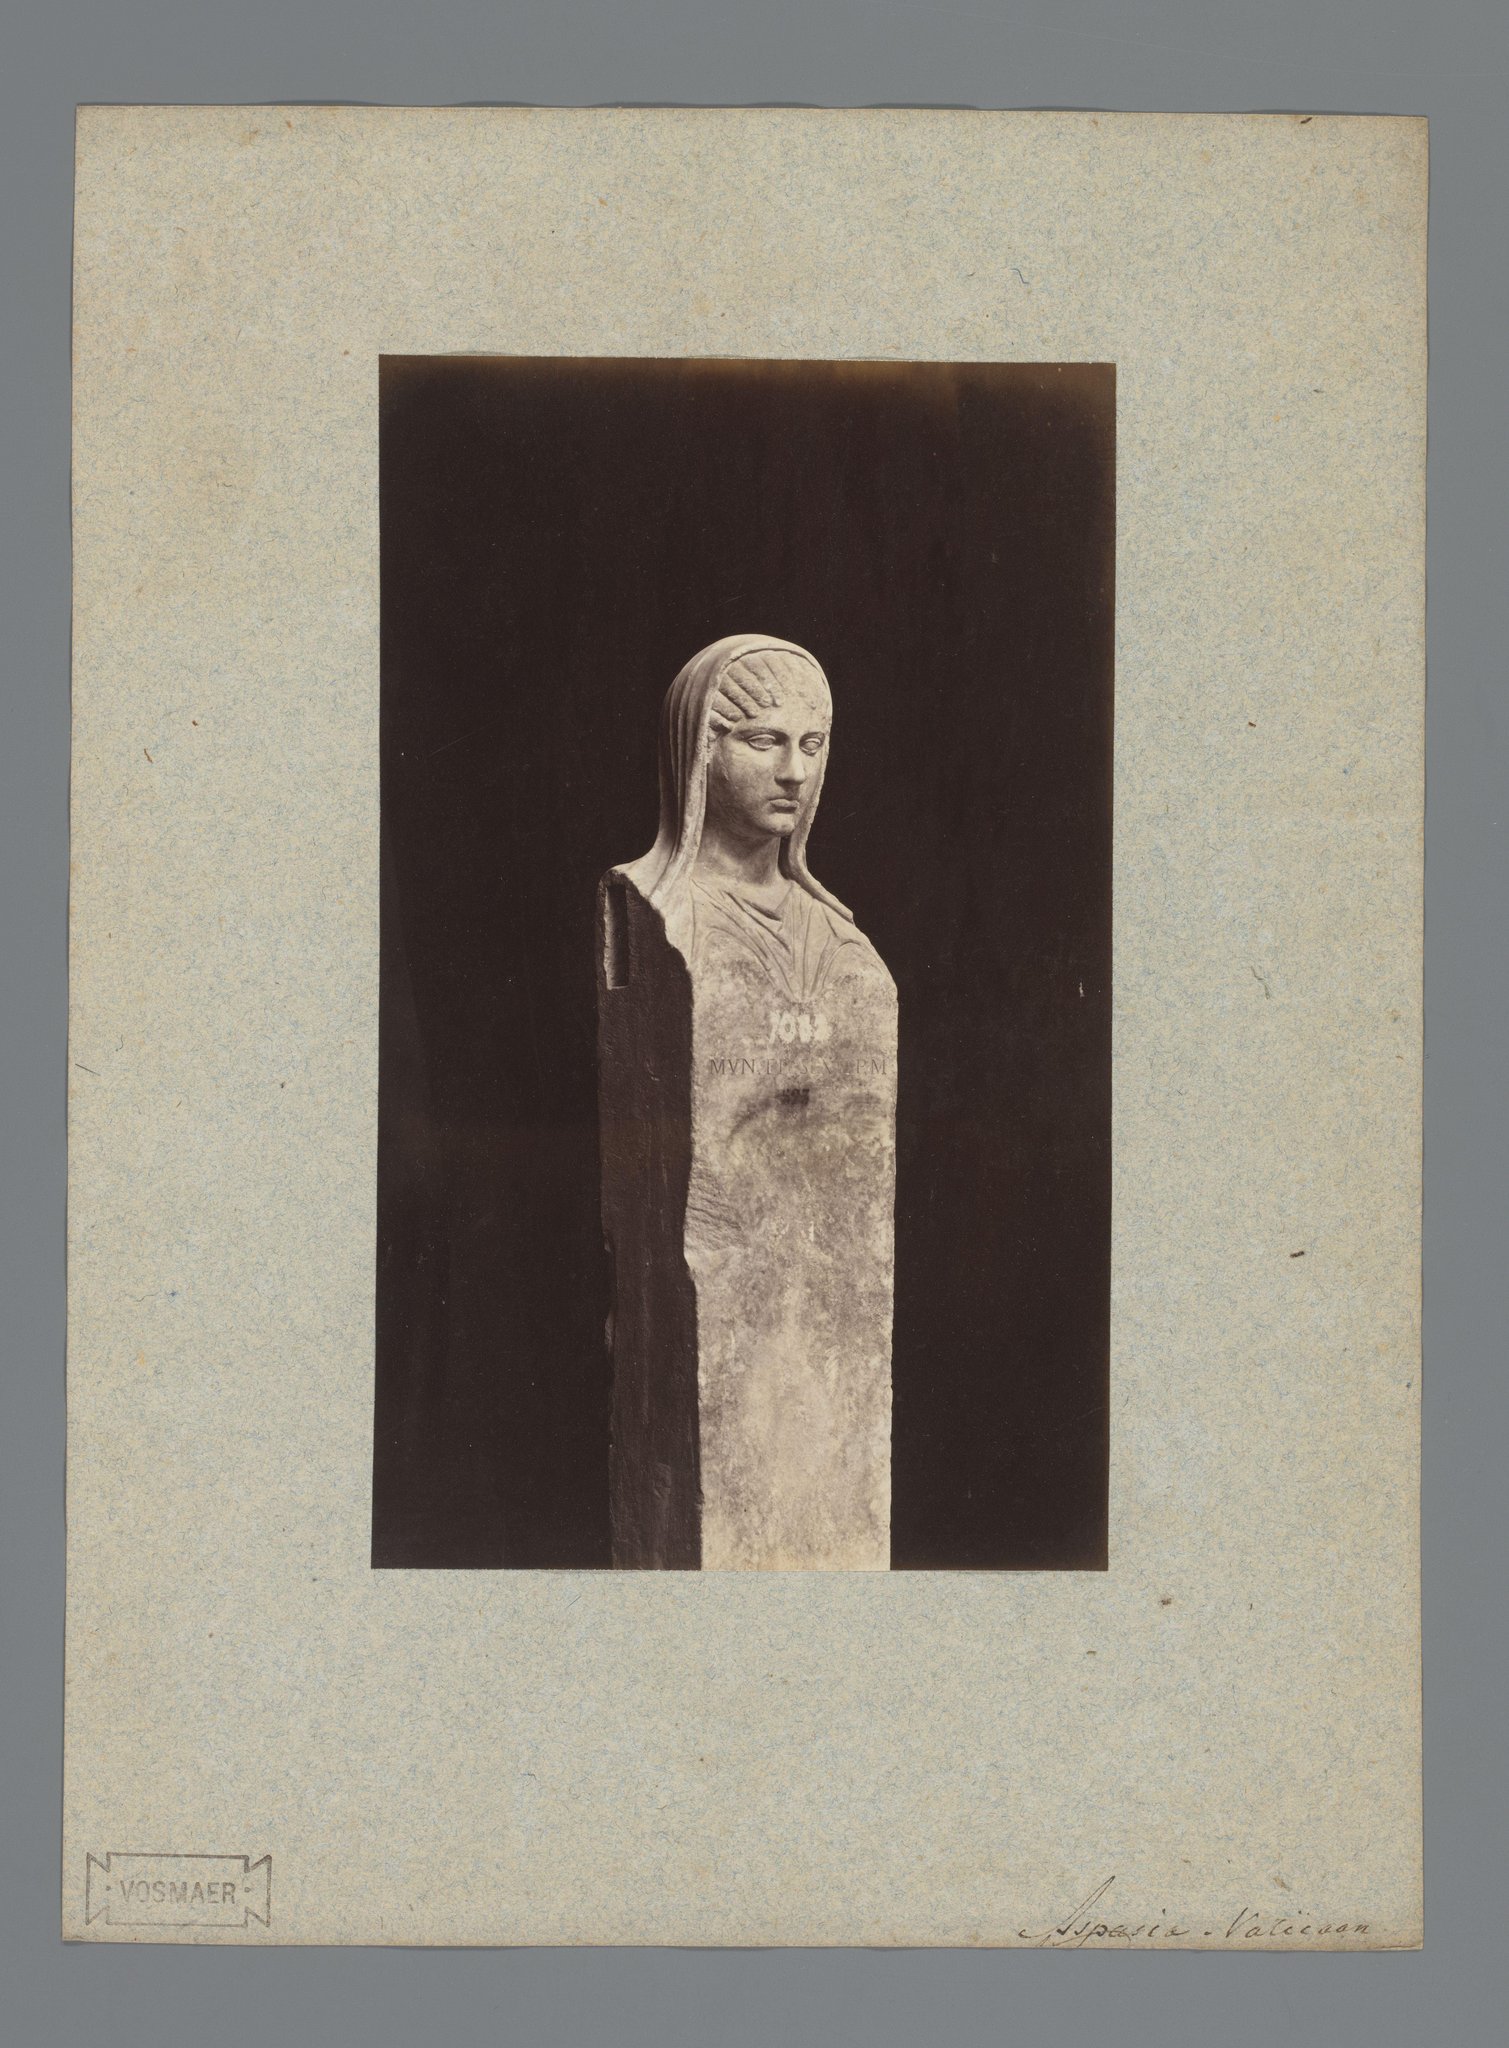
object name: photograph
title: Aspasia Vaticaan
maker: Anonymous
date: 1851-1890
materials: cardboard, paper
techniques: albumen print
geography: vatican city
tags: sculpture, (story of) aspasia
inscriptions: inscription: ‘Geen Aspasia/ Romeinsch werk/ " type/ " kapsel’, collector's mark: ‘VOSMAER’